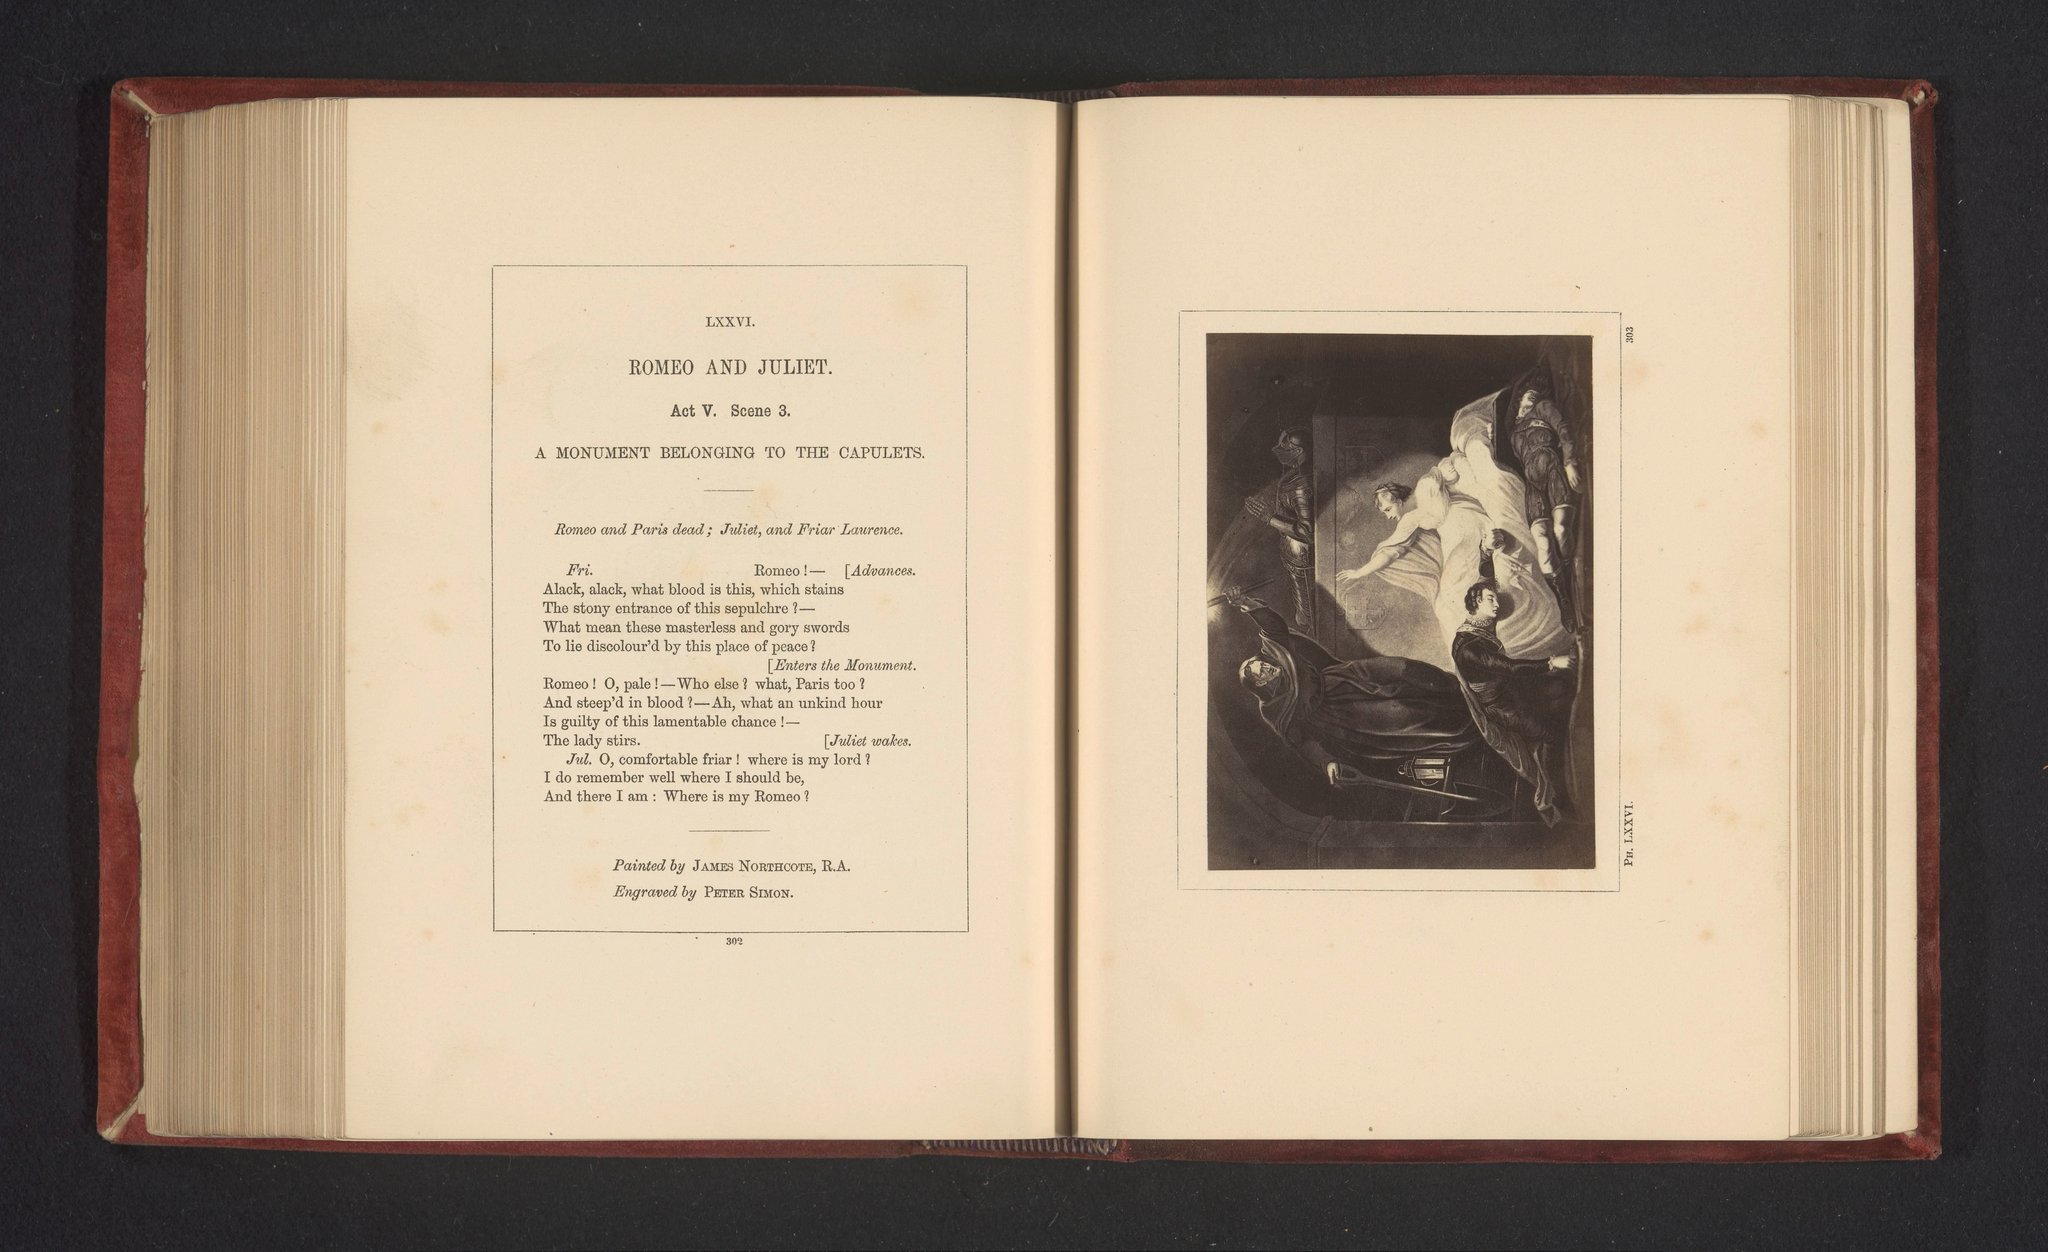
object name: photograph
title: Fotoreproductie van een prent naar een schilderij door James Northcore, voorstellend een scene uit Romeo en Julia door William Shakespeare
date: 1854-1864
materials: photographic support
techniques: albumen print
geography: london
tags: specific works of literature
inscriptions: number: ‘Ph. LXXVI. 303’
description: Te zien is akte V, scene 3 met Romeo en Paris die zijn overleden en Julia die ontwaakt.